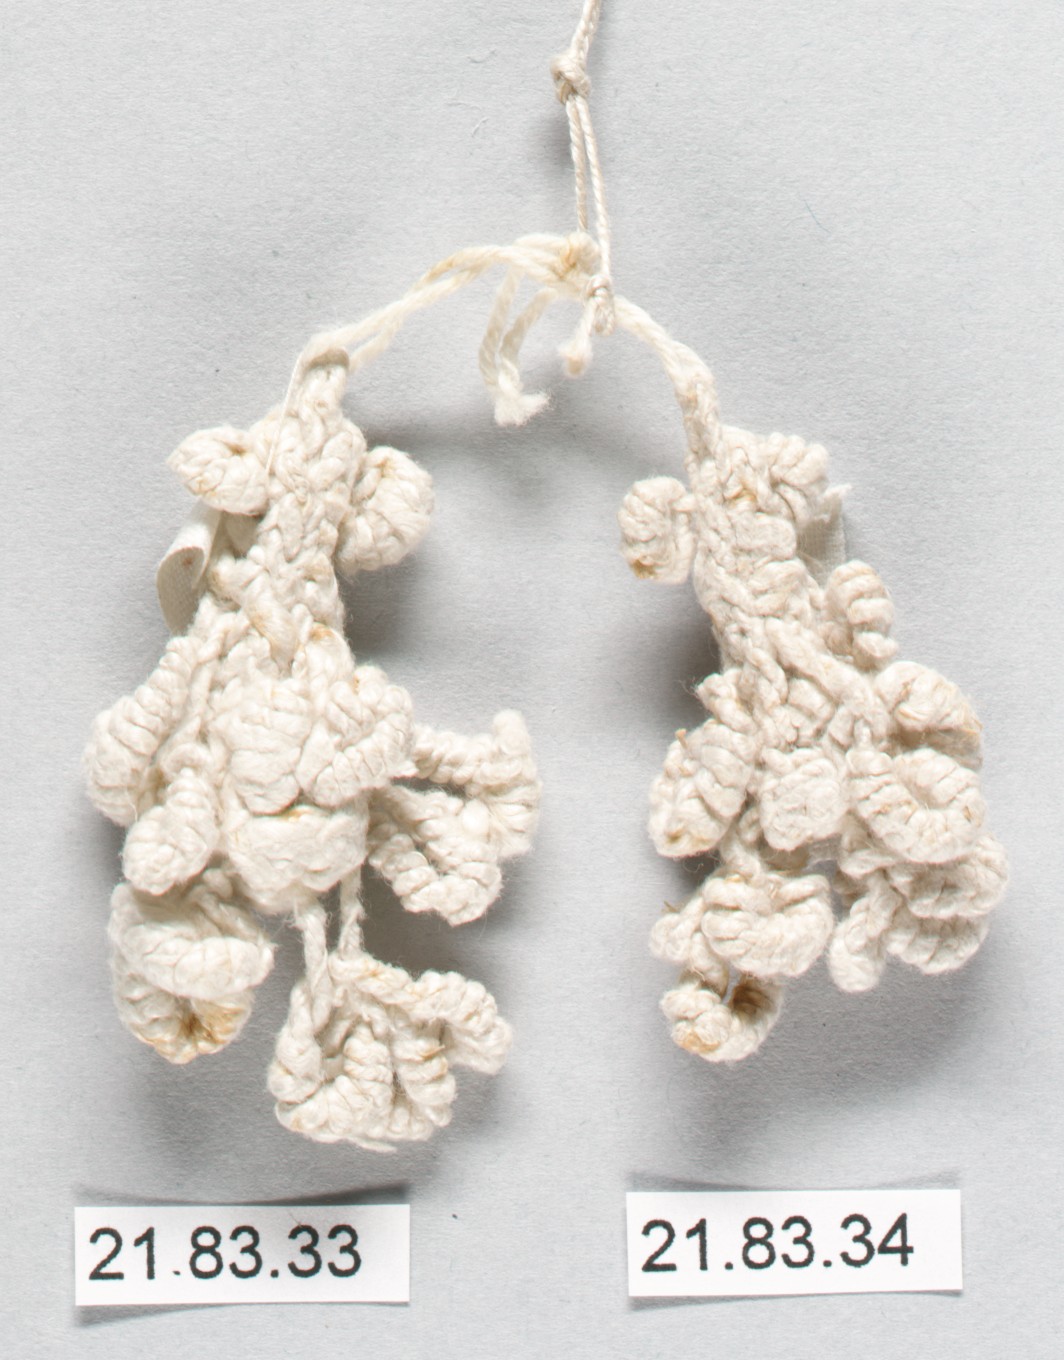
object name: tassel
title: Pair of tassels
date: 1601-1700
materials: linen